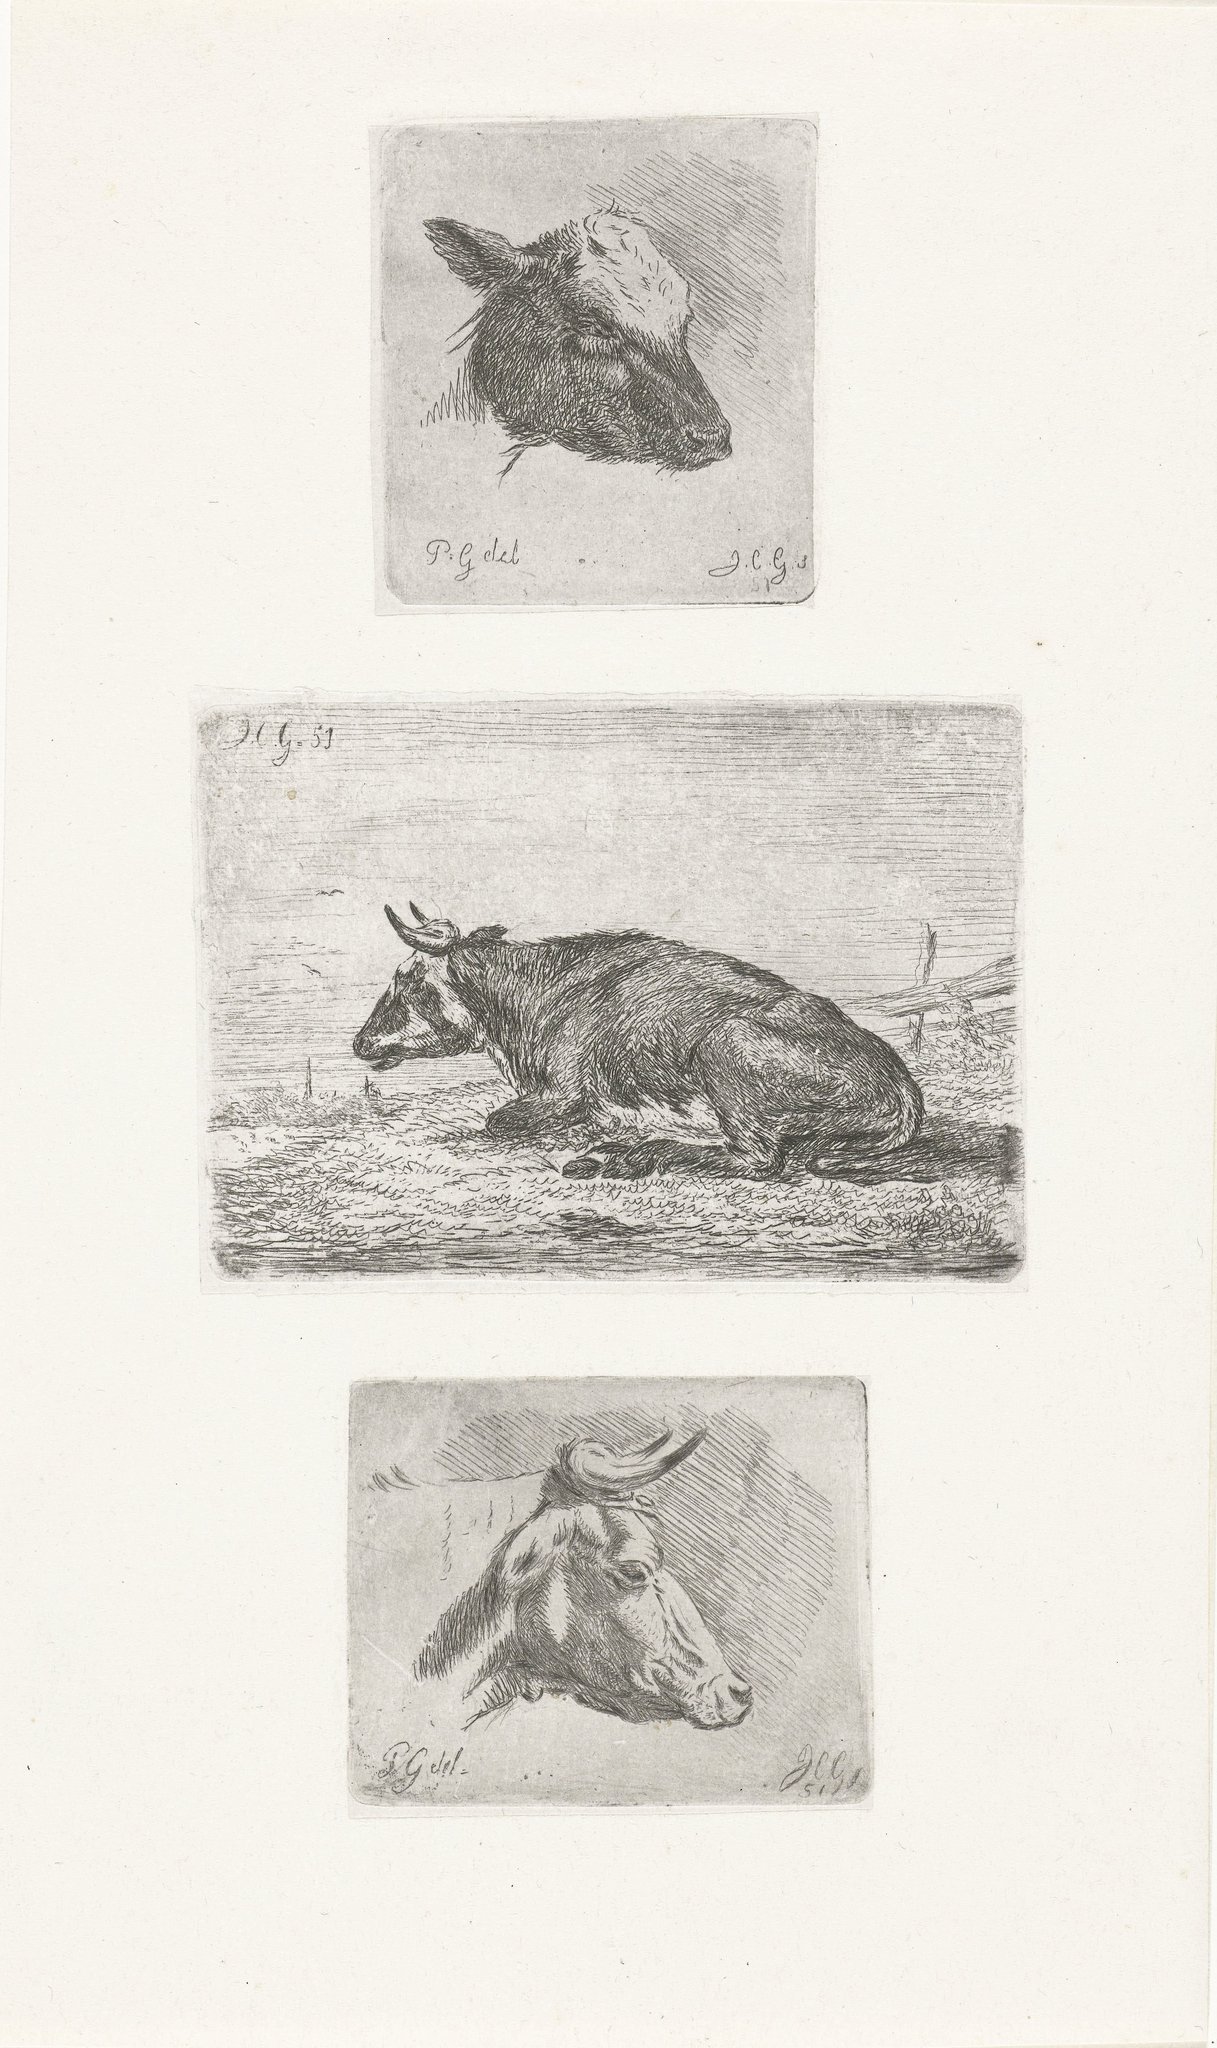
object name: print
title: Kop van een kalf, liggende koe en kop van een stier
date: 1851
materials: paper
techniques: etching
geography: netherlands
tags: bovine cattle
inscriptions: collector's mark: Lugt 2228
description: Drie platen afgedrukt op een vel papier. Boven de kop van een kalf, in het midden een liggende stier en onderaan een stierenkop.